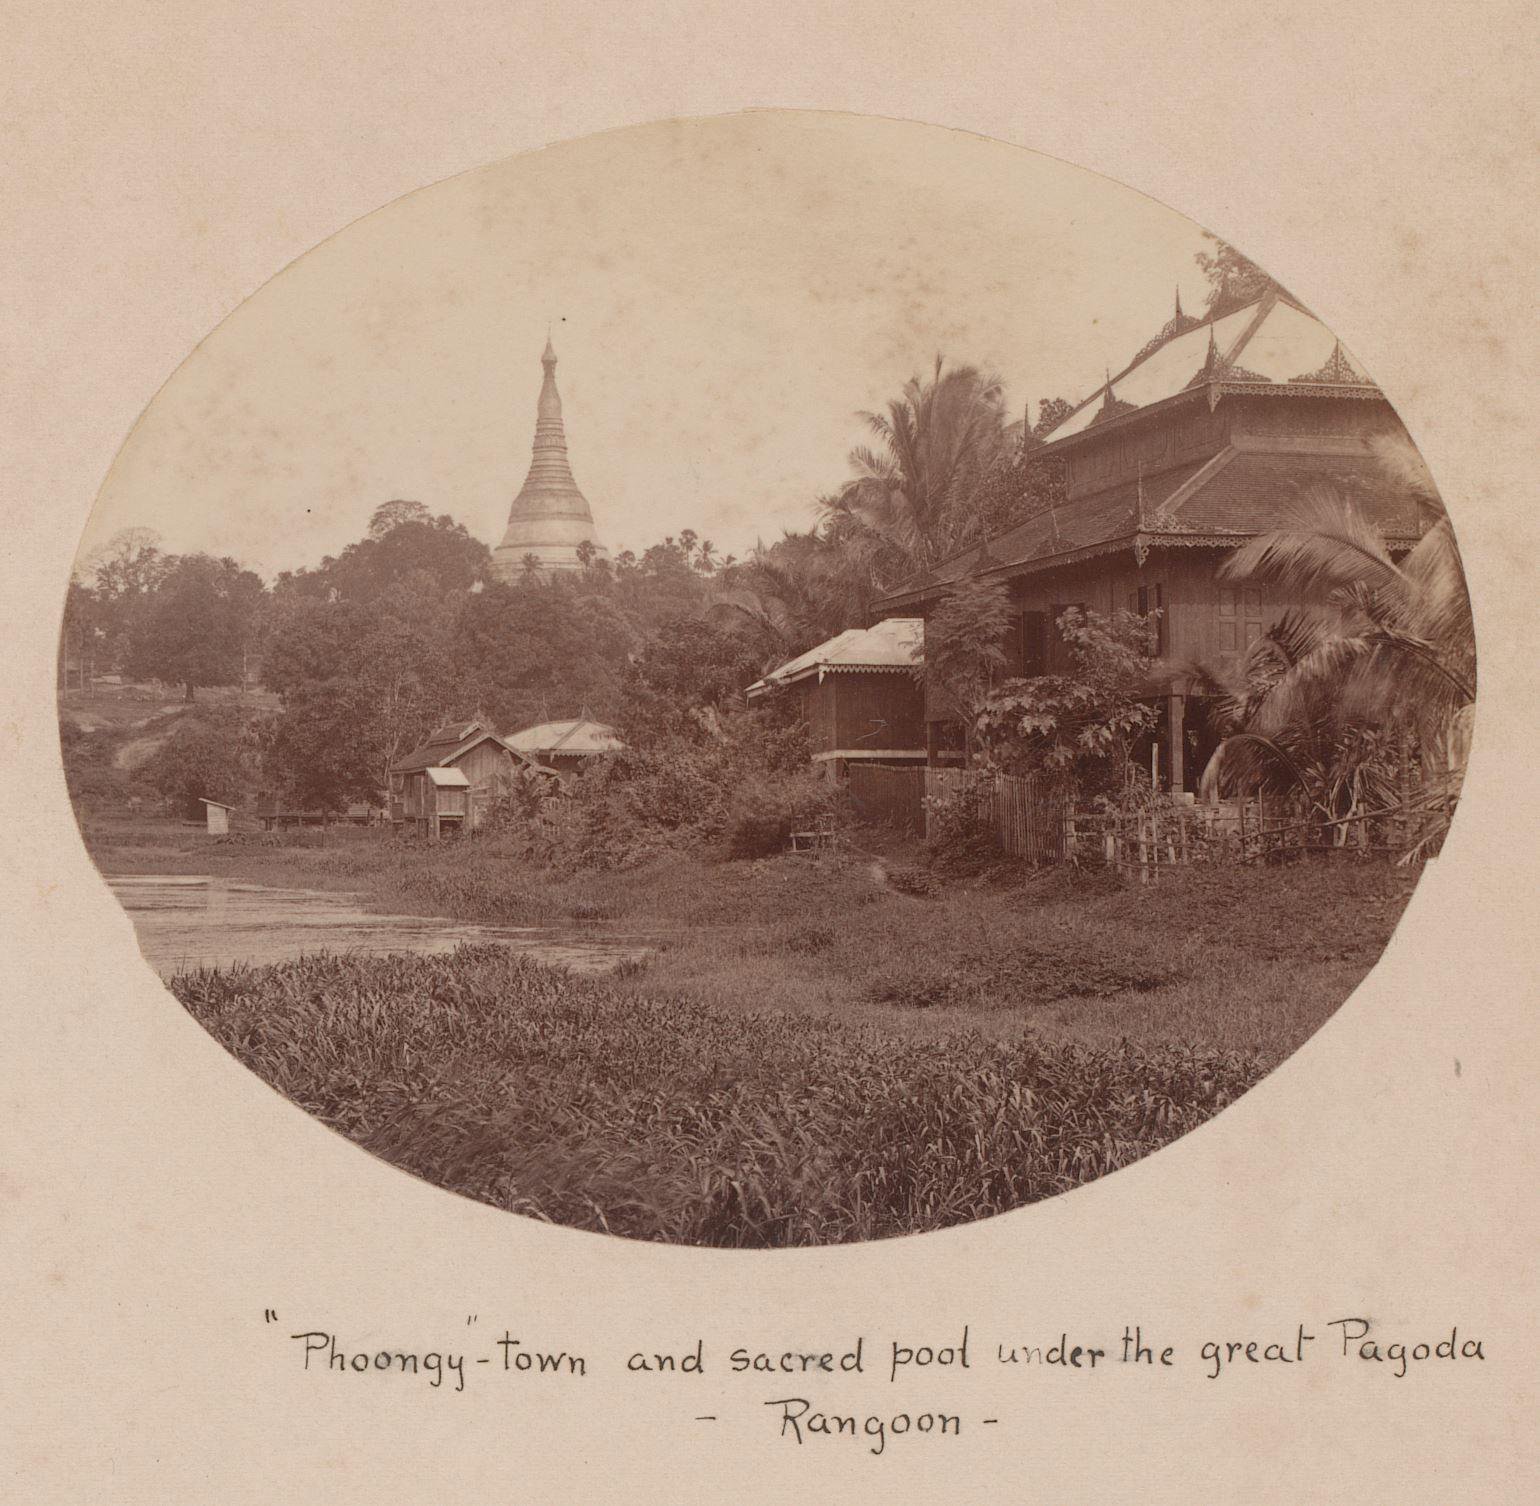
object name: photograph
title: City and sacred pool near the Shwedagon pagoda, Yangon, Myanmar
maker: Anonymous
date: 1870-1900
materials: cardboard, paper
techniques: albumen print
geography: yangon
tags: birma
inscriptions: caption: ‘"Phoongy"- town and sacred pool under the great Pagoda/ - Rangoon -’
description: "Phoongy"-stad en heilige water onder de grote Pagode, Rangoon, Unie van Myanmar (vroeger: Birma).